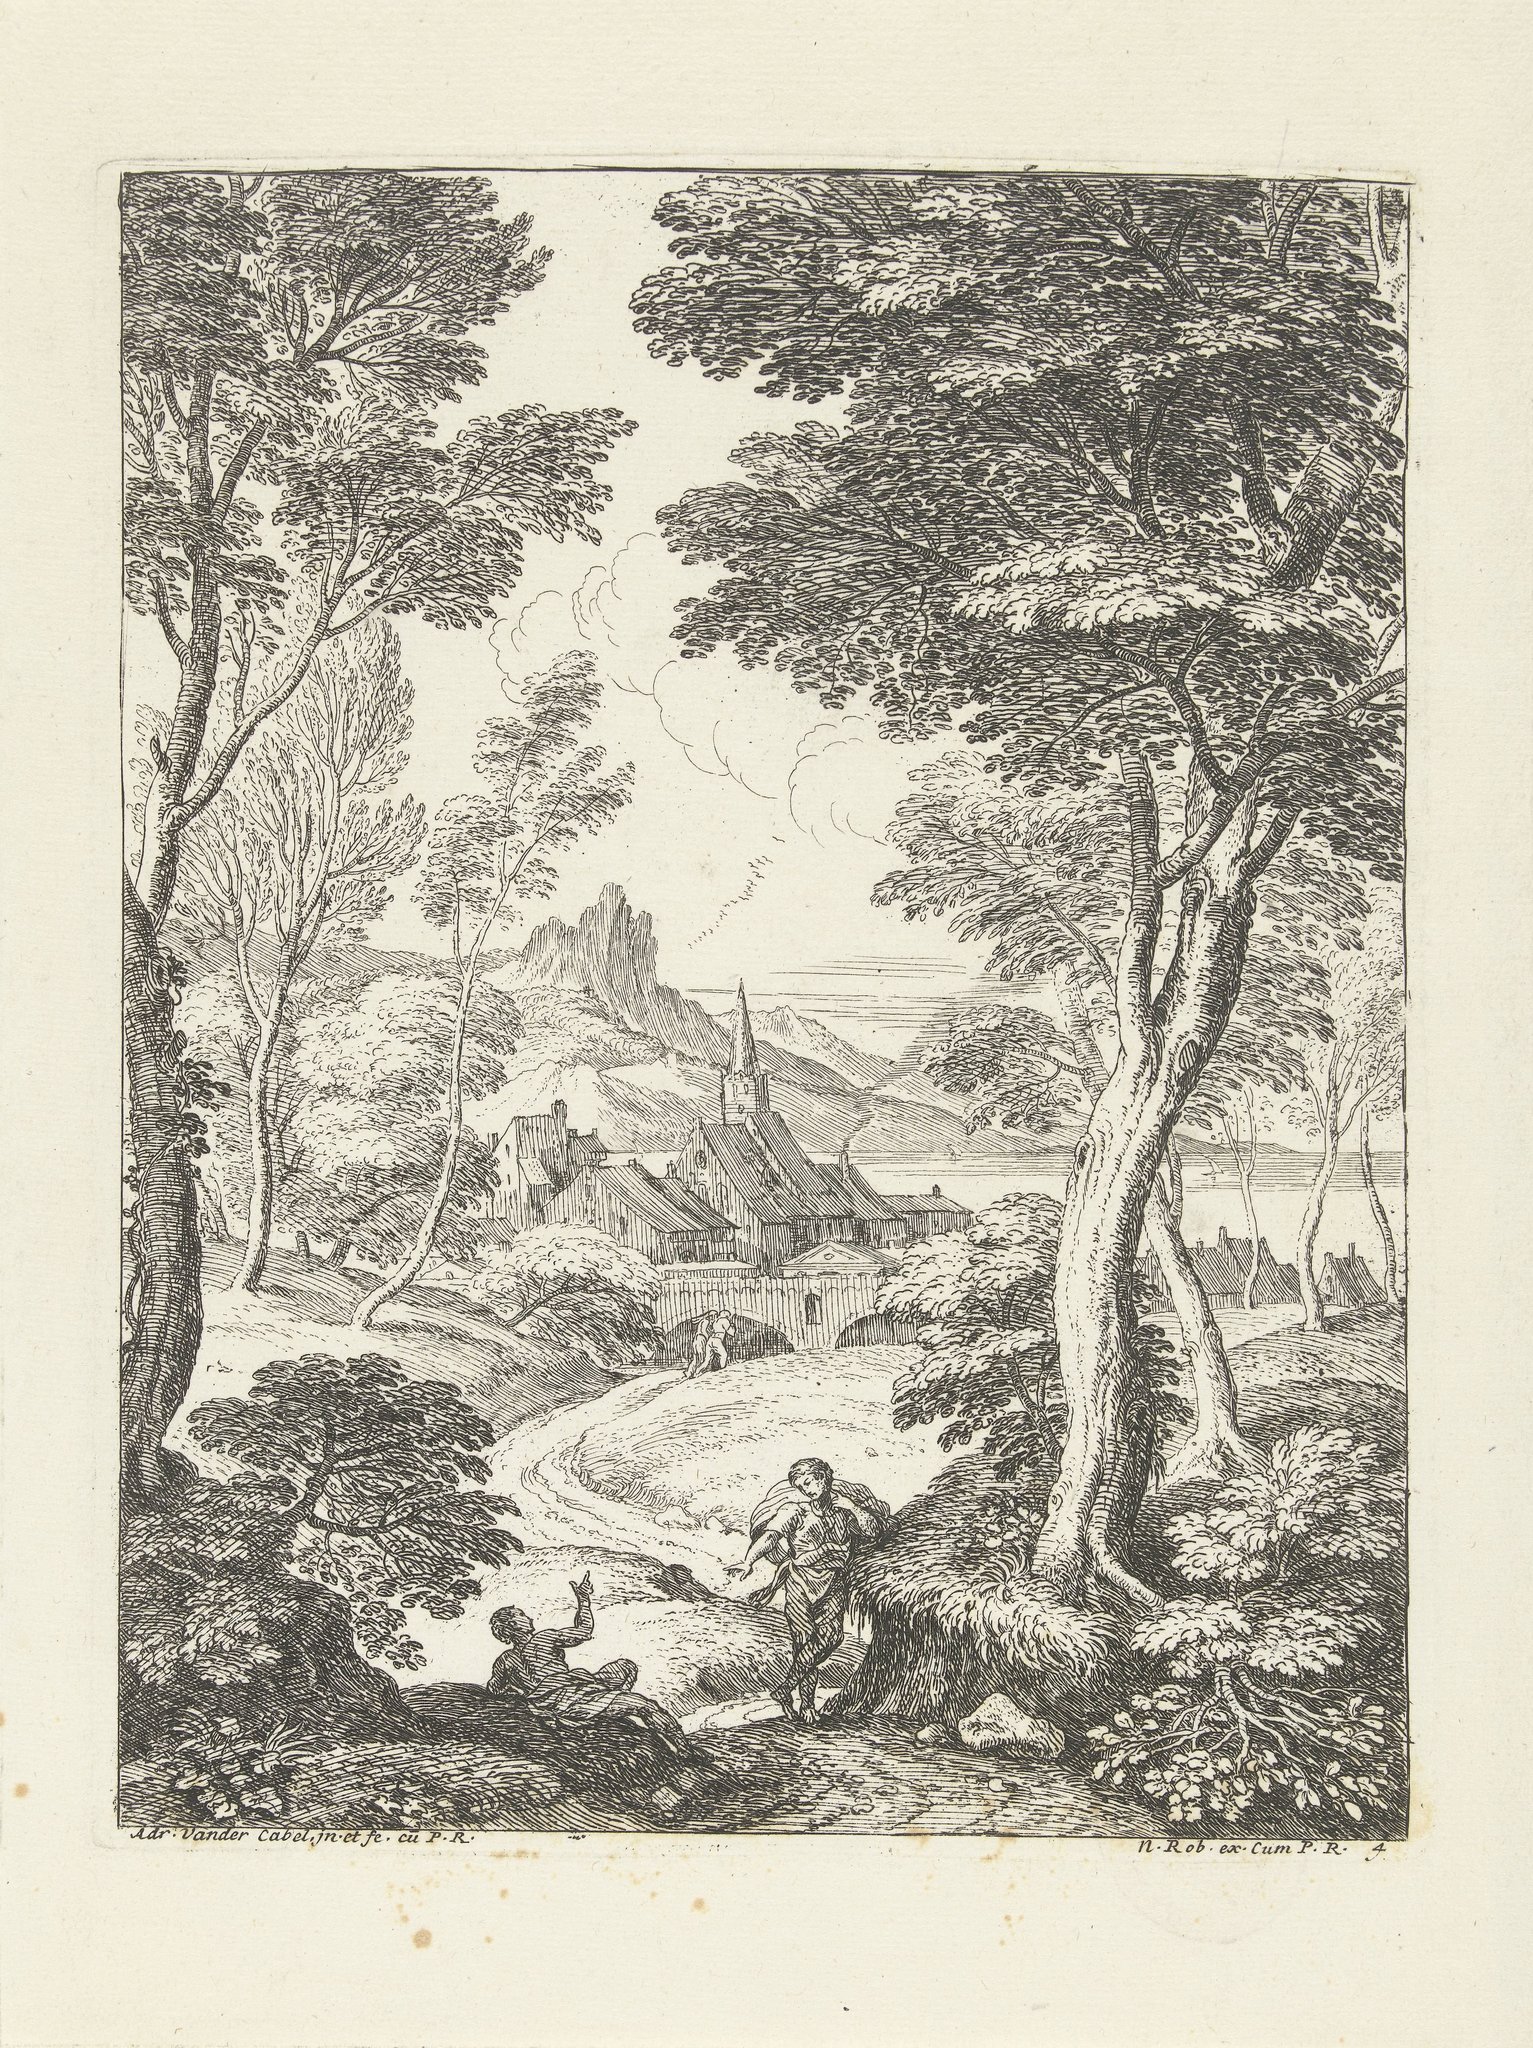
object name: print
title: Landschappen met schaapsherders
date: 1648-1705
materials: paper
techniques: etching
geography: france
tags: landscapes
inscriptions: collector's mark: Lugt 240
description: Landschap met op de voorgrond een staande en liggende man pratend langs een slingerend pad; op de achtergrond een stad met spitse kerktoren.